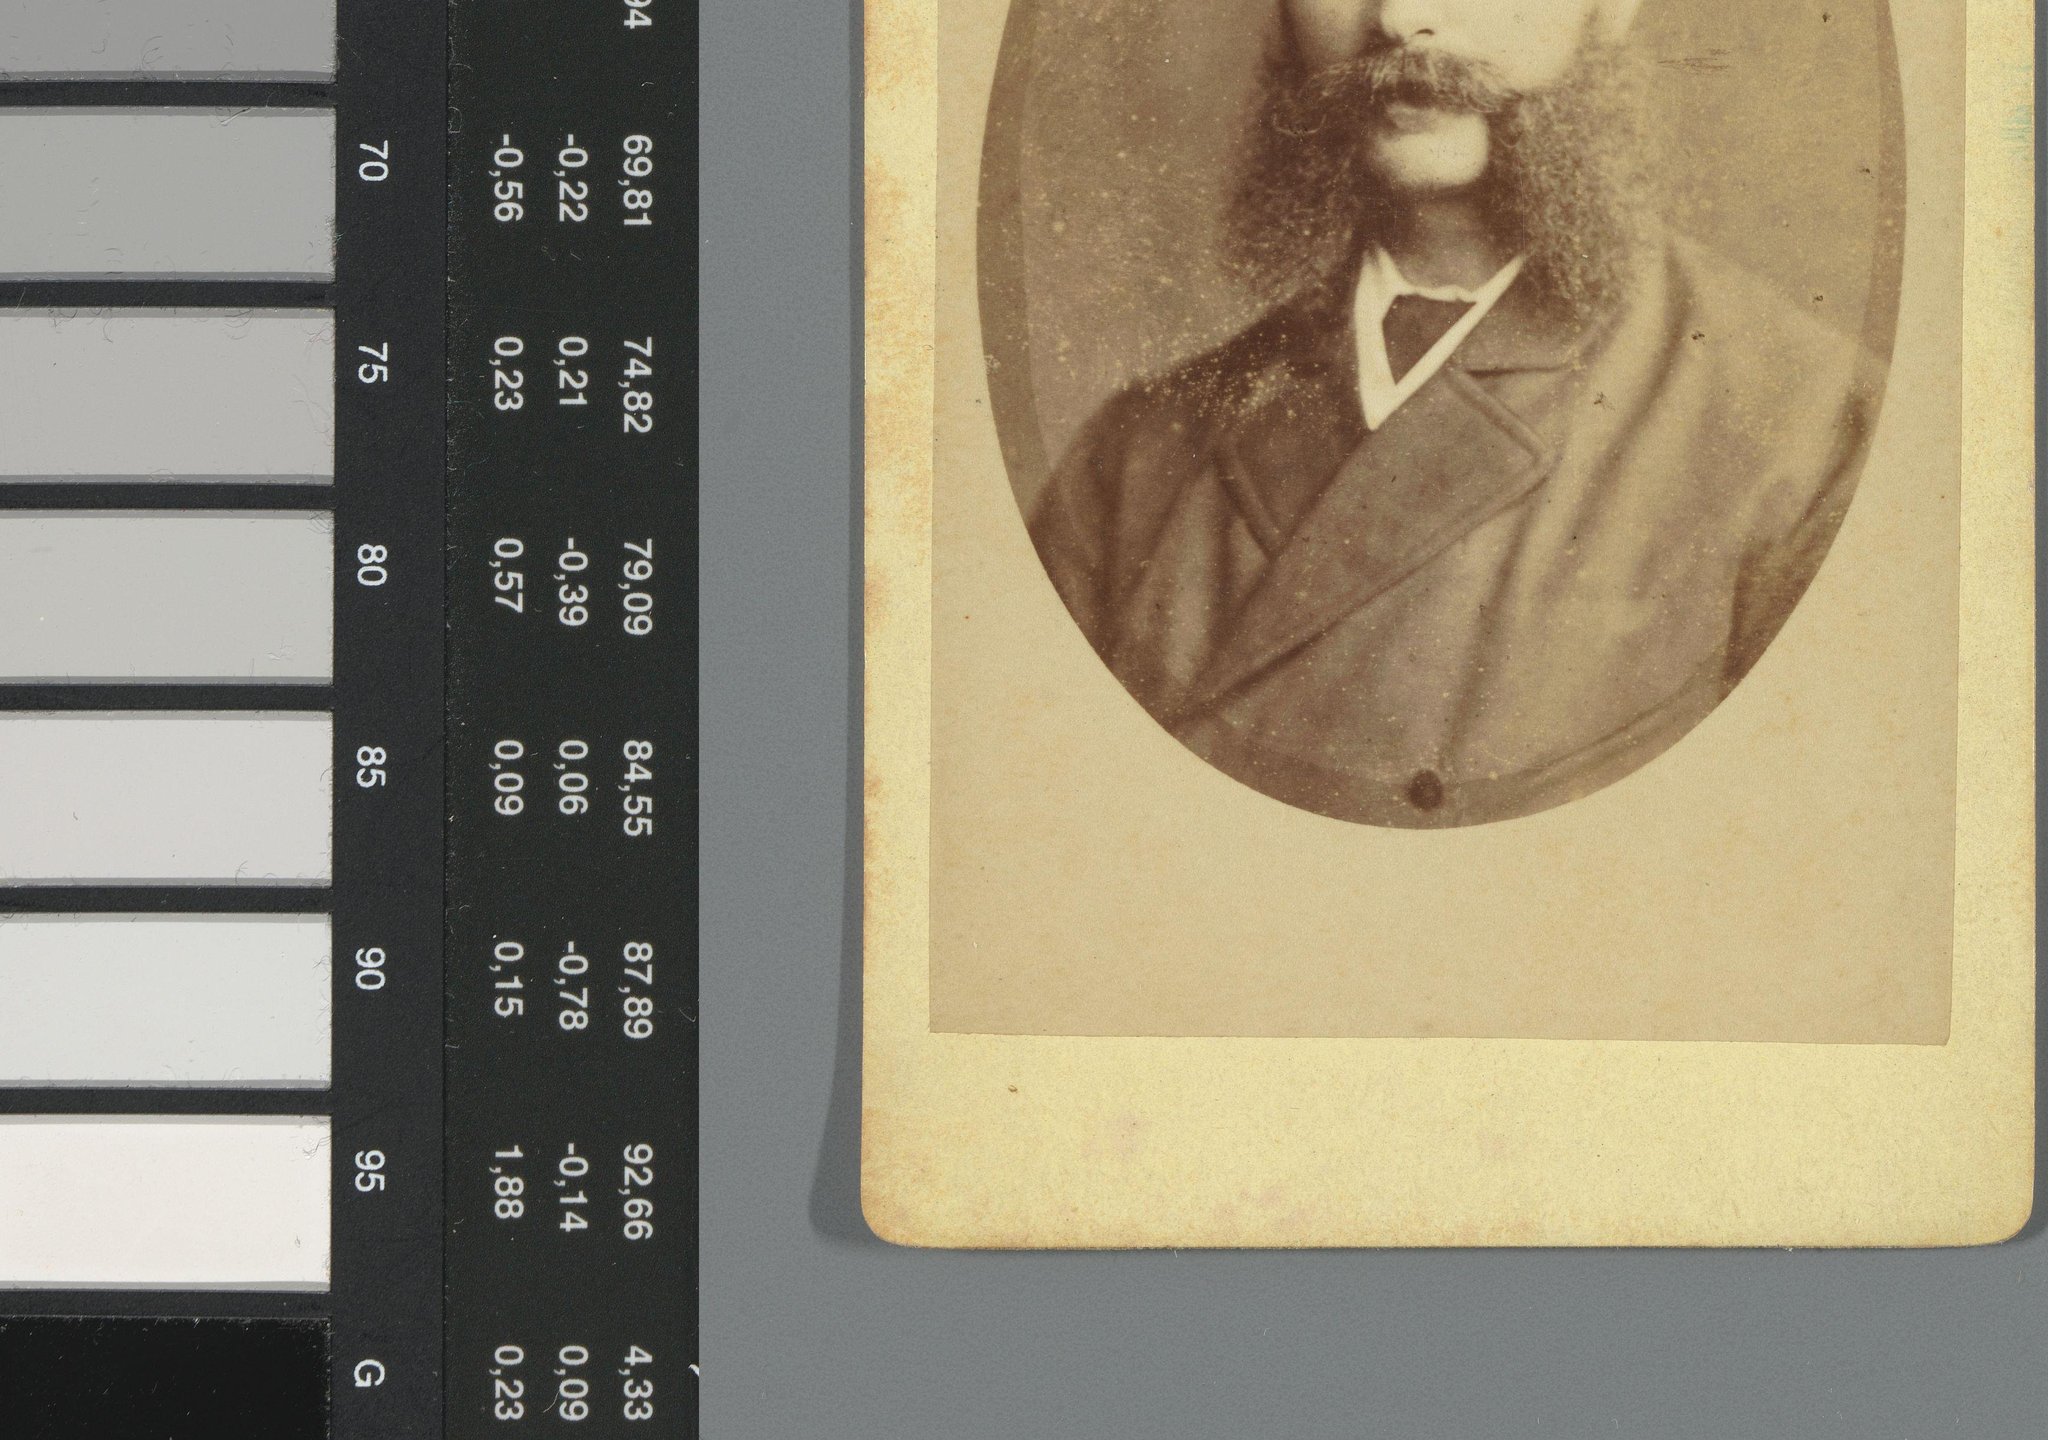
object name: carte de visite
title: Portret van een onbekende man met bakkebaarden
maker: Anonymous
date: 1890-1895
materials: cardboard, photographic support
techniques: albumen print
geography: netherlands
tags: sideburns, historical persons not known by name, netherlands